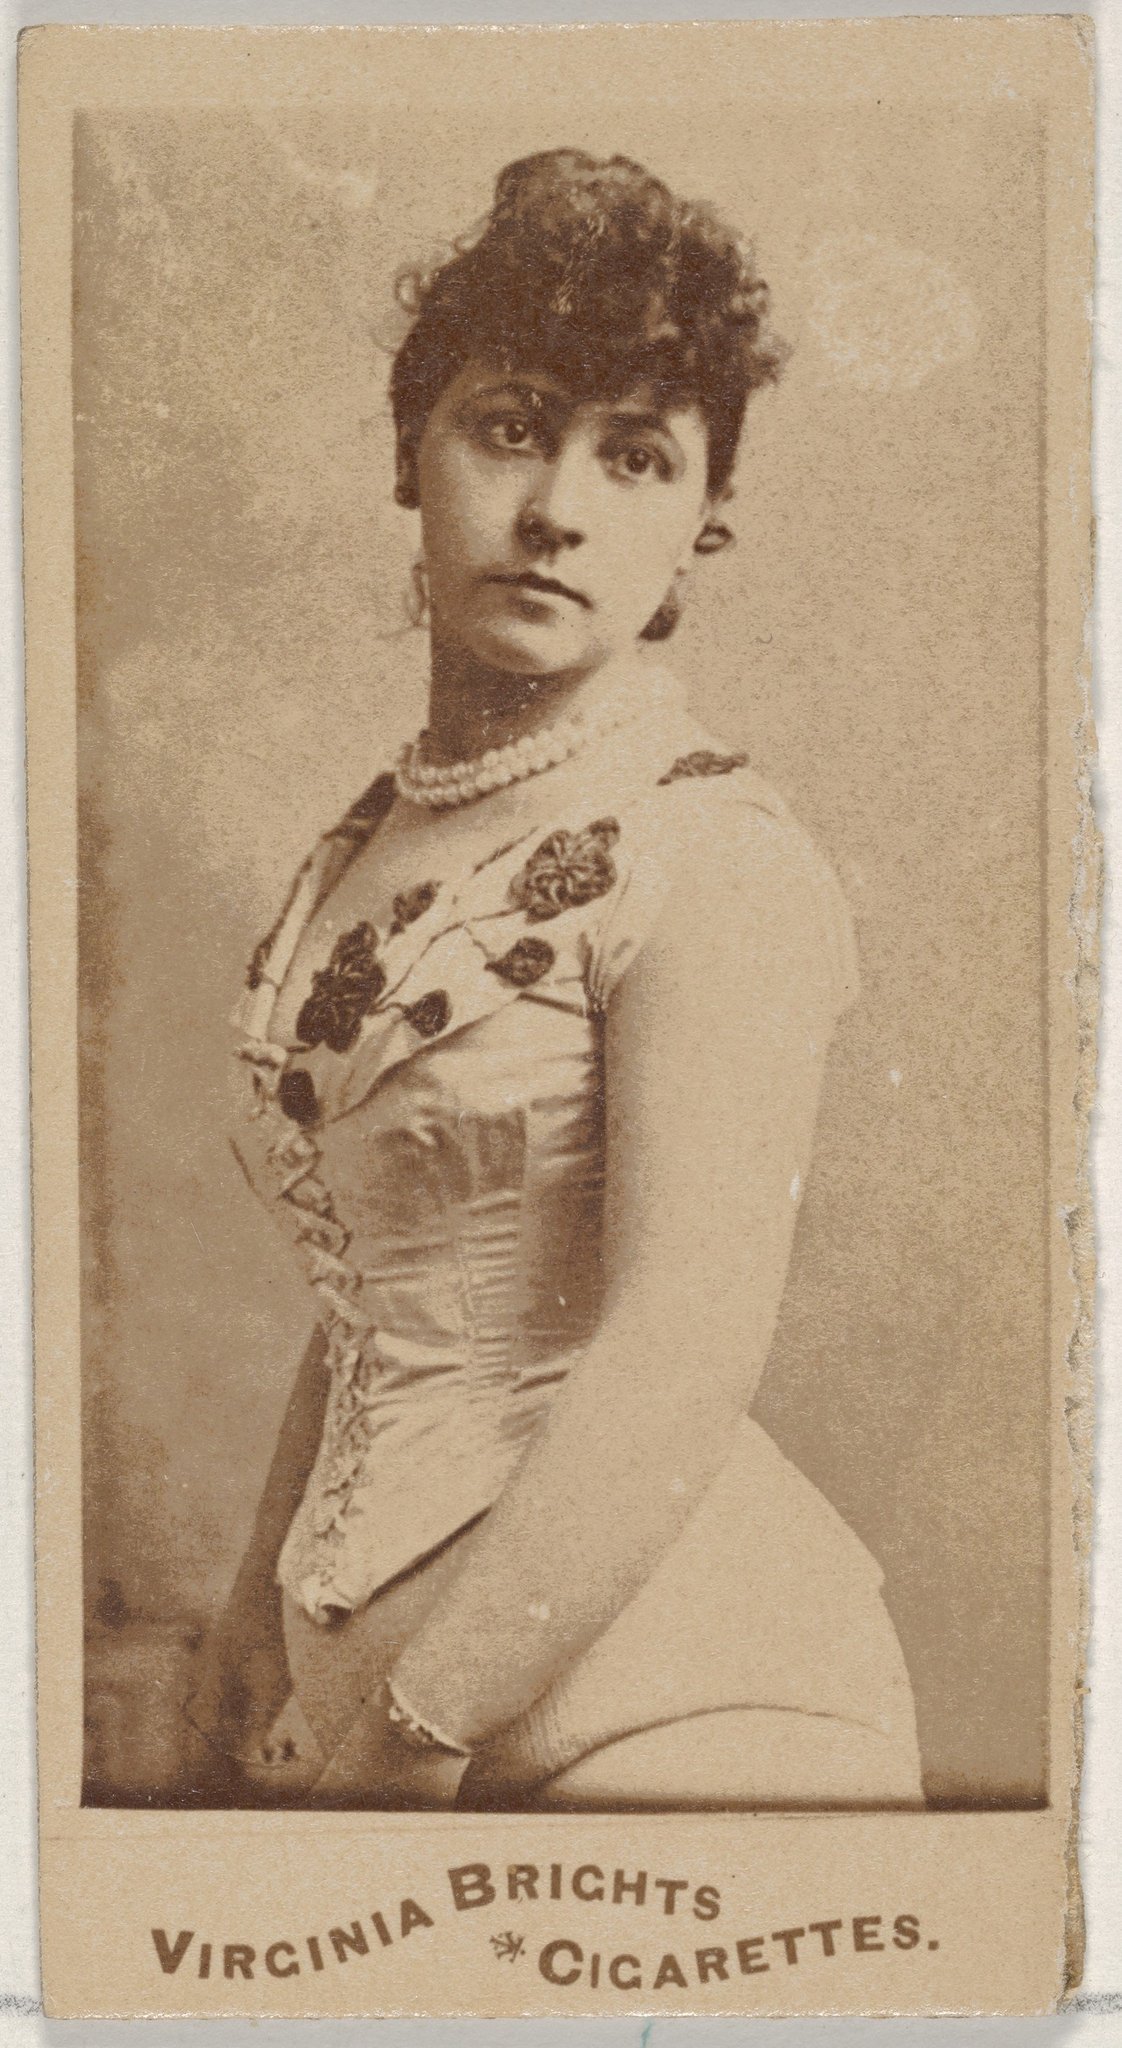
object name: photograph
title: From the Actors and Actresses series (N45, Type 5) for Virginia Brights Cigarettes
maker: allen & ginter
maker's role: publisher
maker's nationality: american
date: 1888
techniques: albumen silver print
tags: portraits,women,actresses